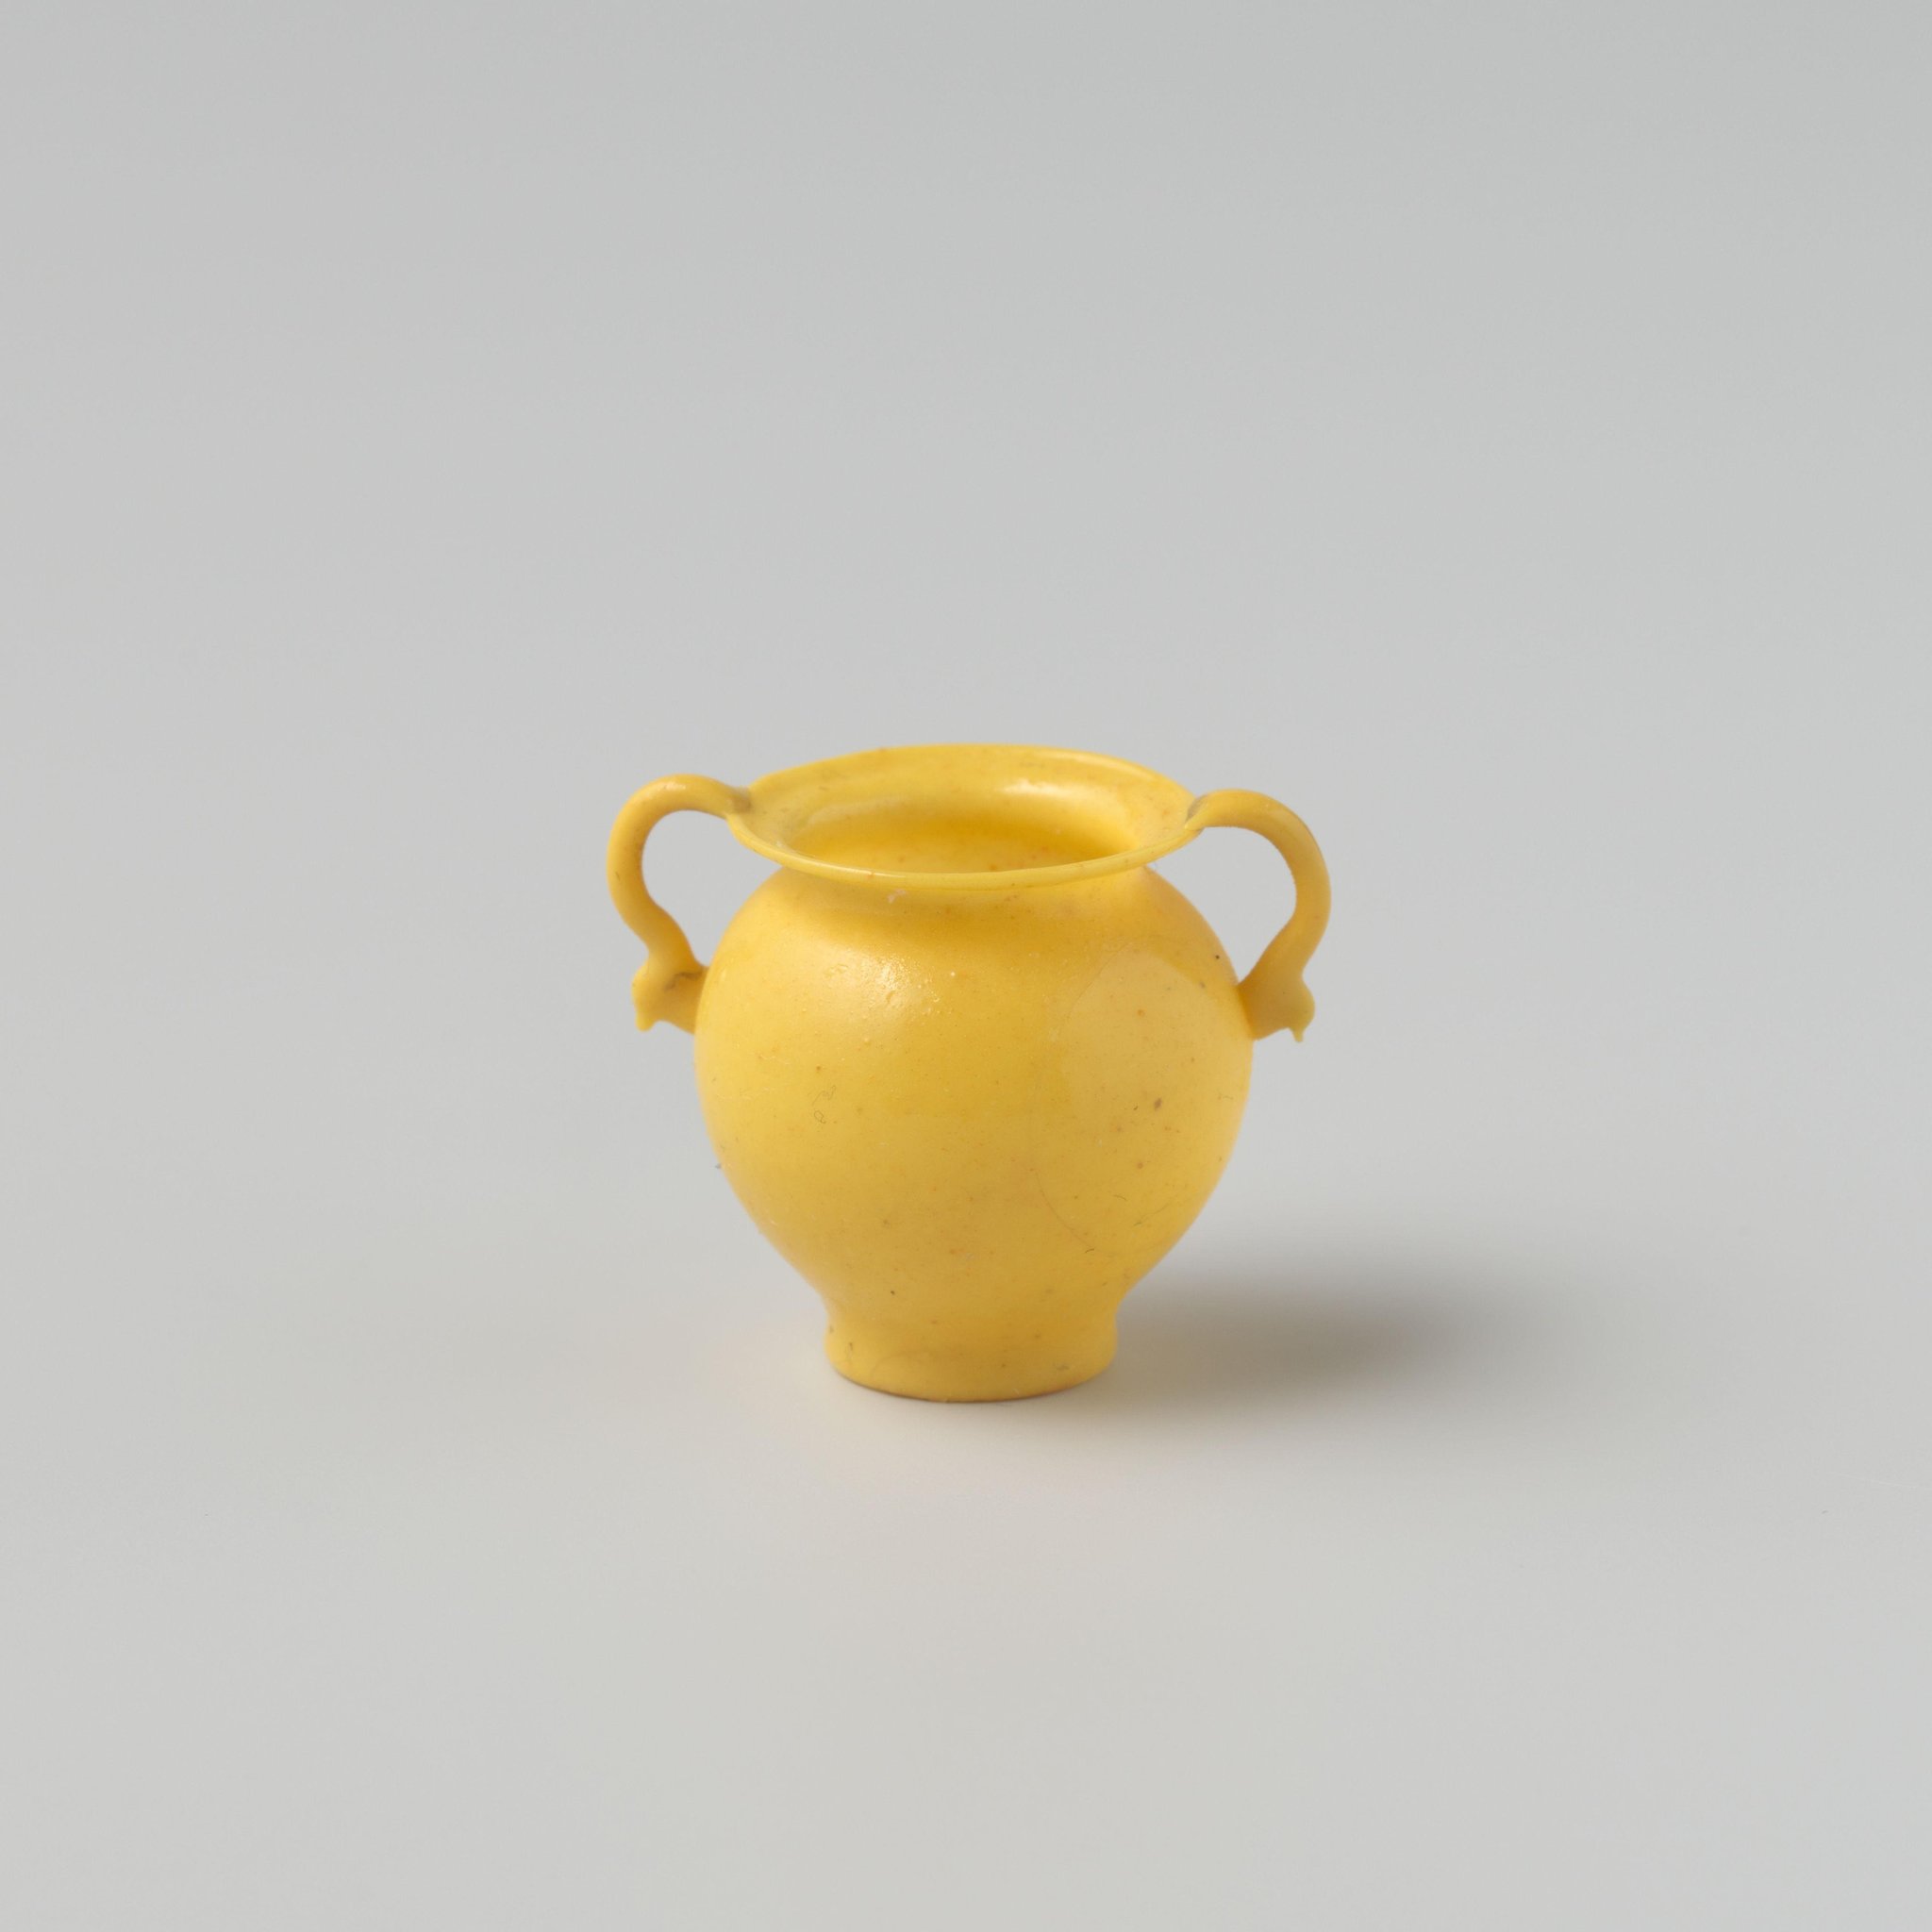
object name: pot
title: Pot van opaak geel glas (waarschijnlijk imitatie geel aardewerk), rond model met twee aangezette oren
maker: Anonymous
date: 1675-1710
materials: glass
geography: amsterdam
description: Pot van opaak geel glas, waarschijnlijk imitatie geel aardewerk; rond model met twee aangezette oren.